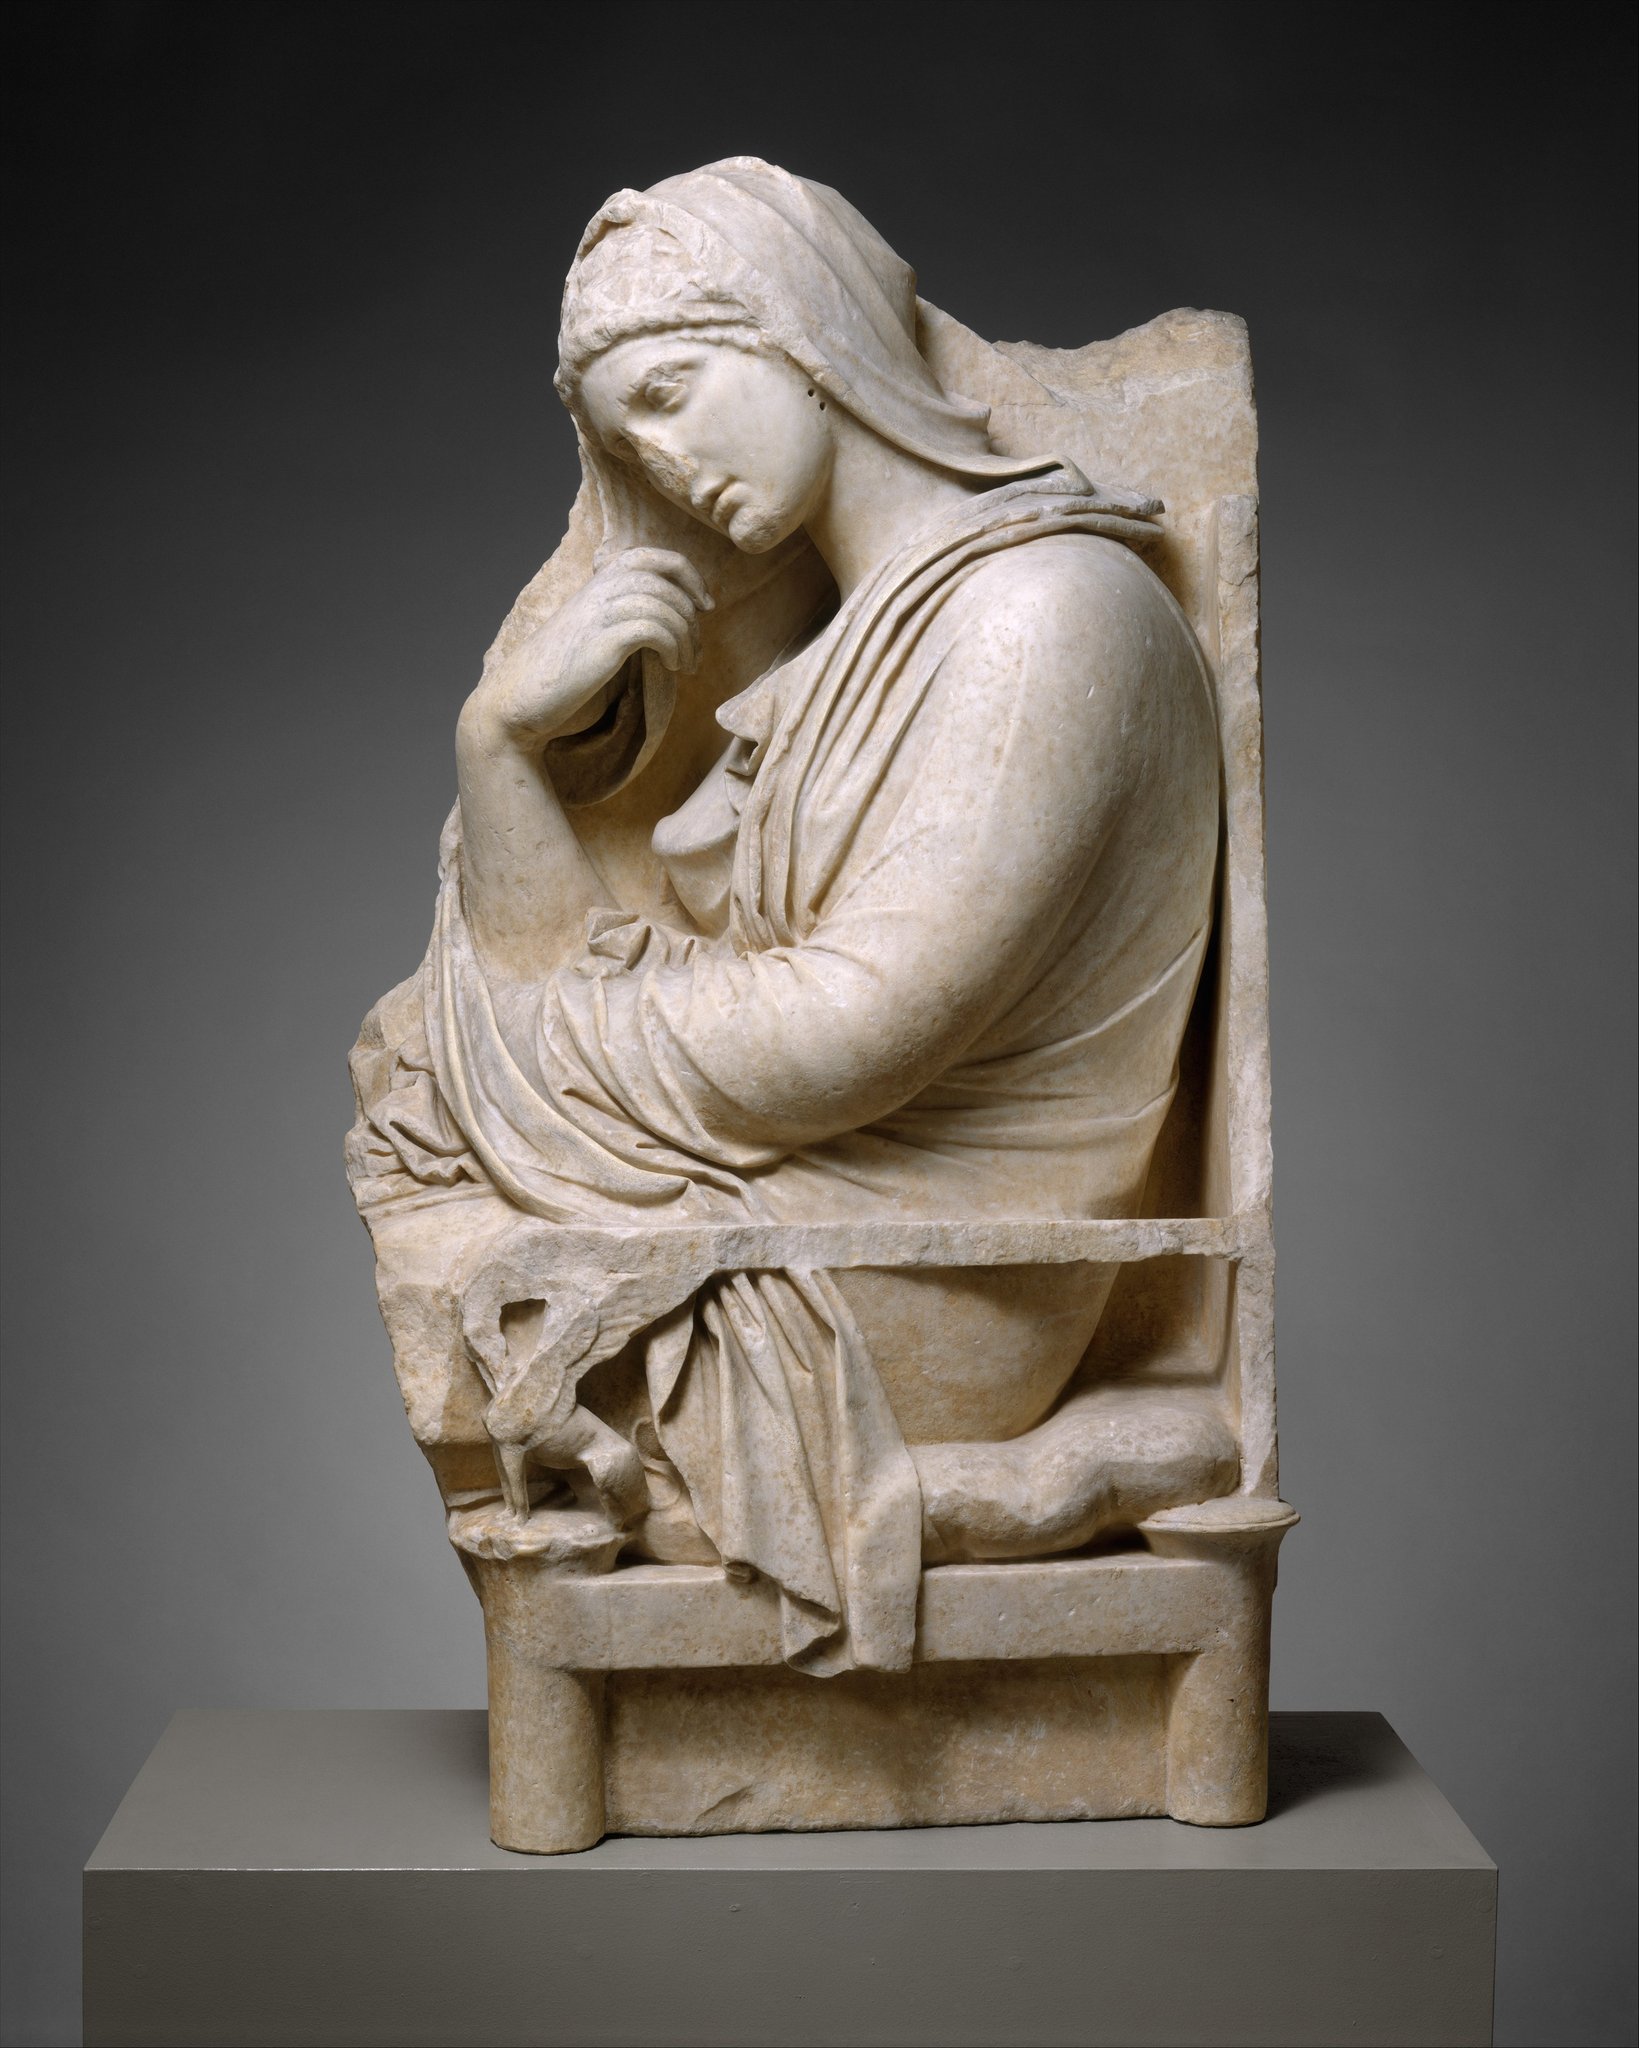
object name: grave relief with enthroned woman, fragment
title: Marble stele (grave marker) of a woman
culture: greek, attic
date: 367-335 BCE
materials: marble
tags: women